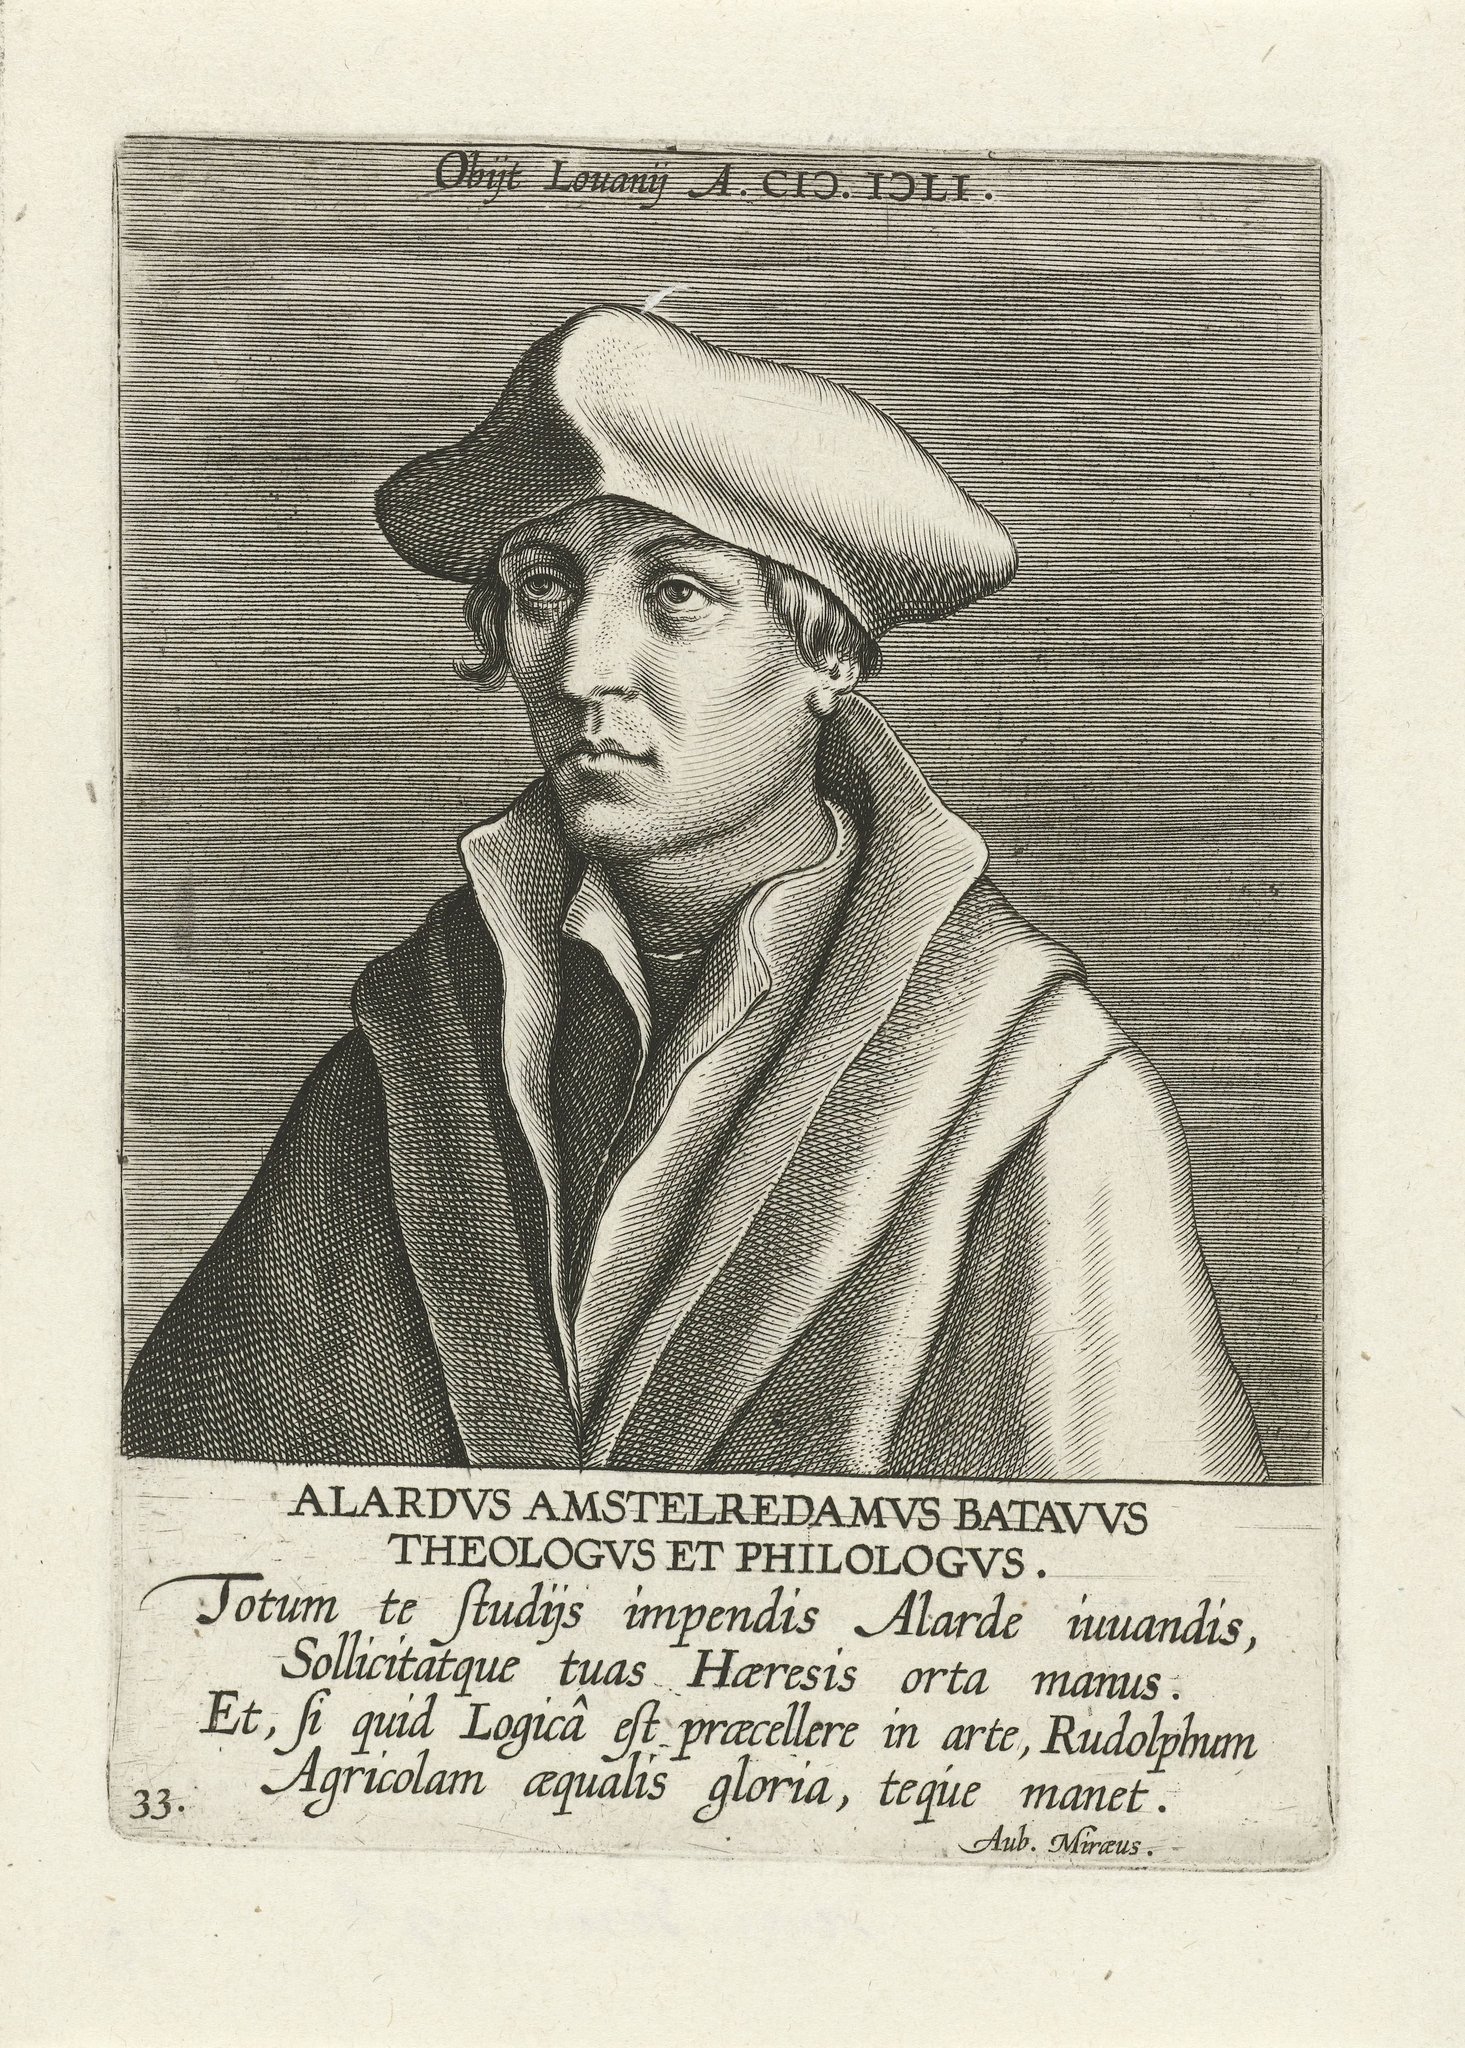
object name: print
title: Portret van Alardus van Amsterdam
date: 1604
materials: paper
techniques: engraving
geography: antwerp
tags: amsterdam, louvain, allard van amsterdam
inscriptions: collector's mark: Lugt 2228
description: Portret van Alardus van Amsterdam, een beroemde humanist uit Amsterdam. Buste naar links. De prent heeft een Latijns boven- en onderschrift en maakt deel uit van een serie van beroemde Nederlandse en Vlaamse geleerden.